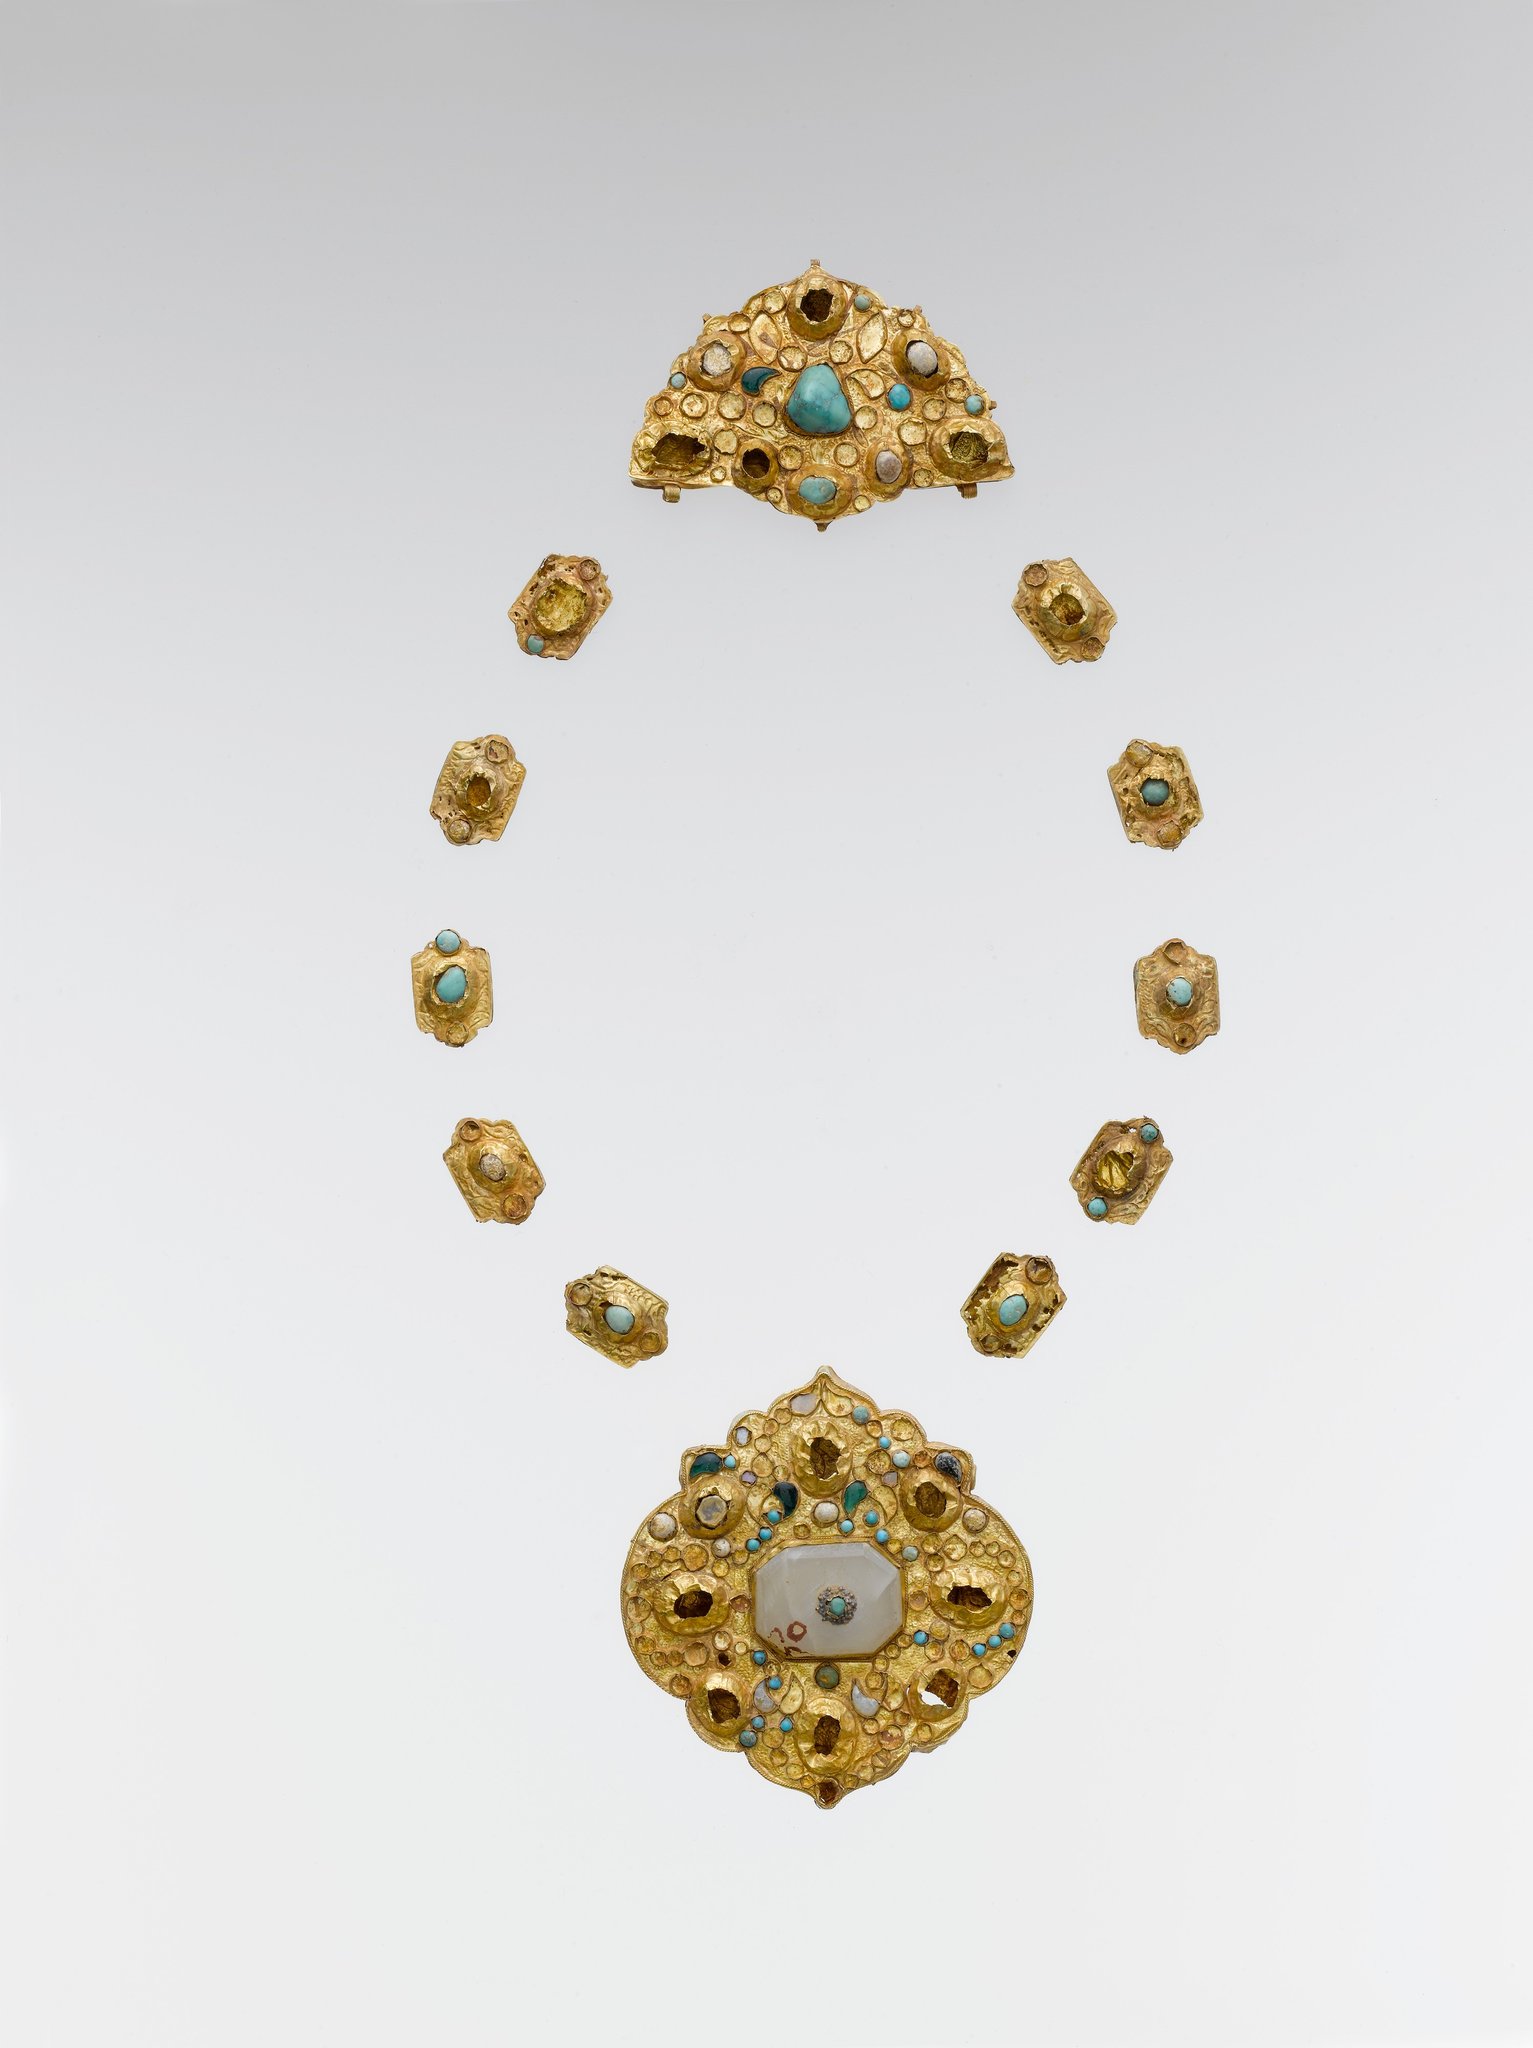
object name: necklace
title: Jewelry Elements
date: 1367-1600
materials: stone, glass, gold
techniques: chasing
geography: iran